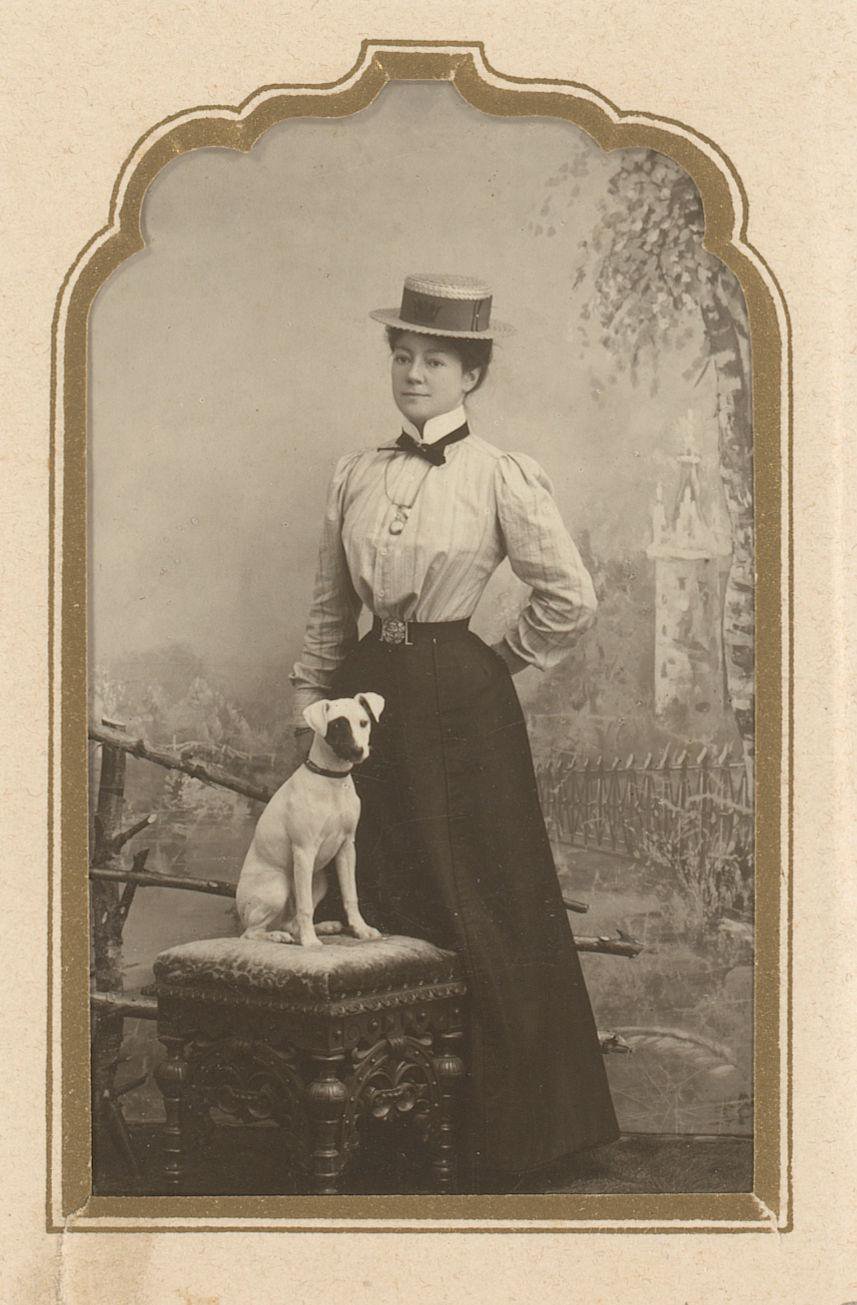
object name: carte de visite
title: Portret van een staande vrouw met hoed en een hond zittend op een kruk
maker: o. sundberg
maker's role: fotograaf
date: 1890-1920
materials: cardboard, photographic support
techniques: collodion silver print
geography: söderhamn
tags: historical persons - bb - woman, head-gear: hat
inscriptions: inscription: ‘O. Sundberg/ Söderhamn’